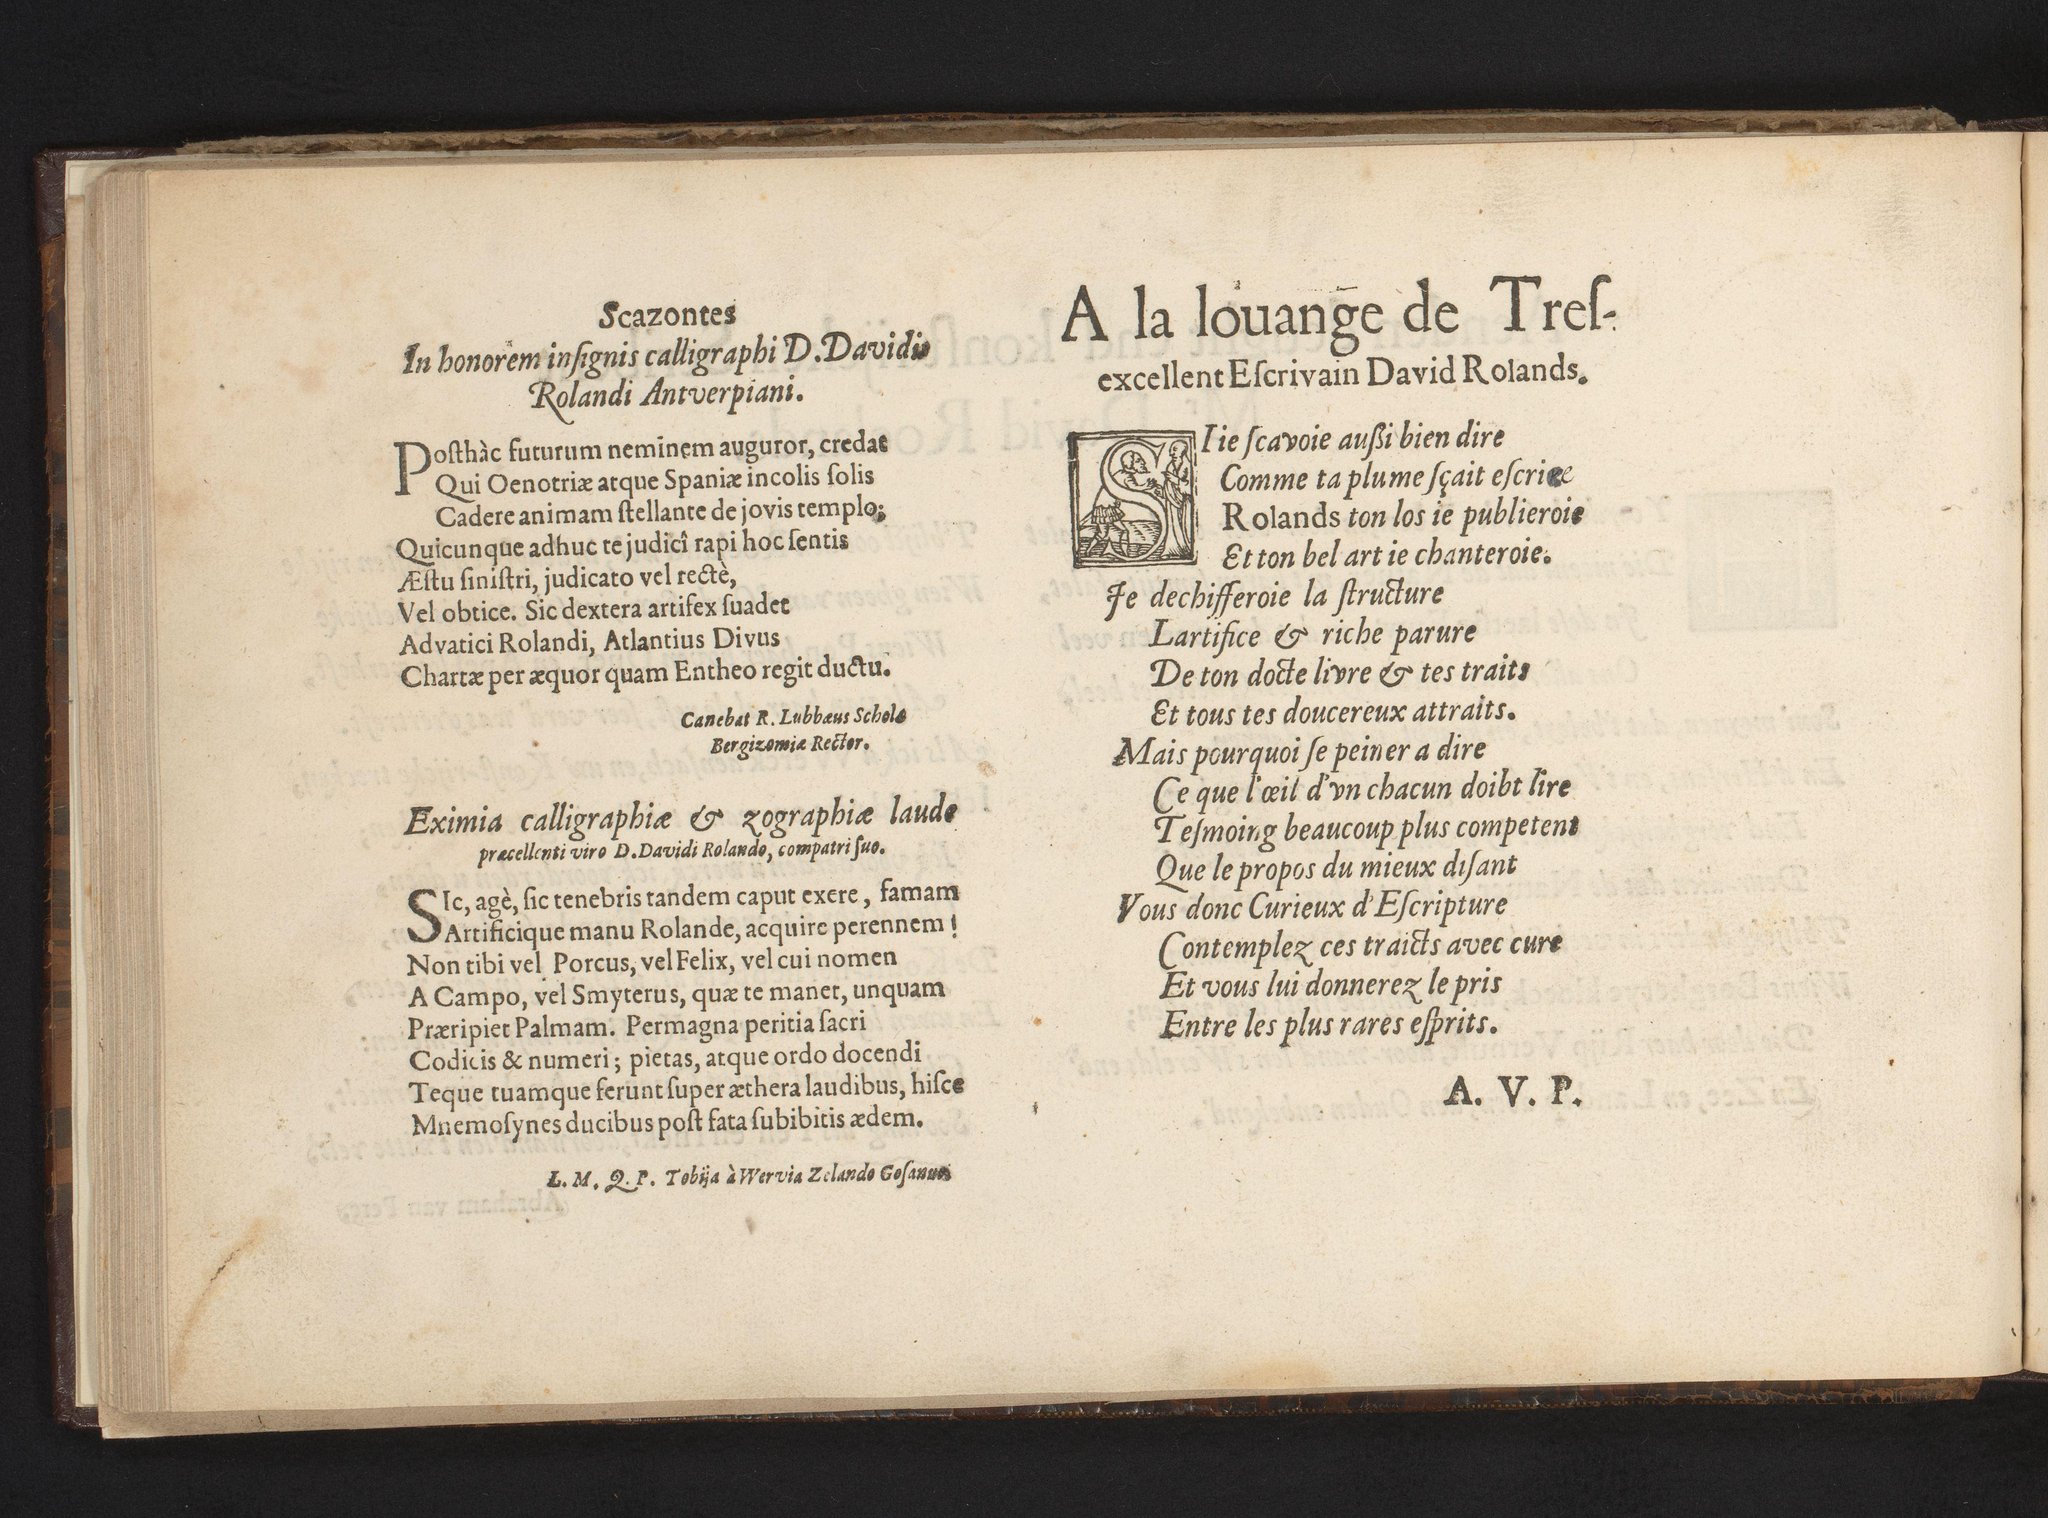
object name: text sheet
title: Drie drempeldichten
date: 1616-1617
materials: paper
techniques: letterpress printing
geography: flushing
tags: initial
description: Tekstblad met drie drempeldichten in het Latijn en Frans, opgedragen aan David Roelands. Het Franstalige gedicht begint met een gehistorieerde initiaal S. Het tekstblad maakt deel uit van een album.